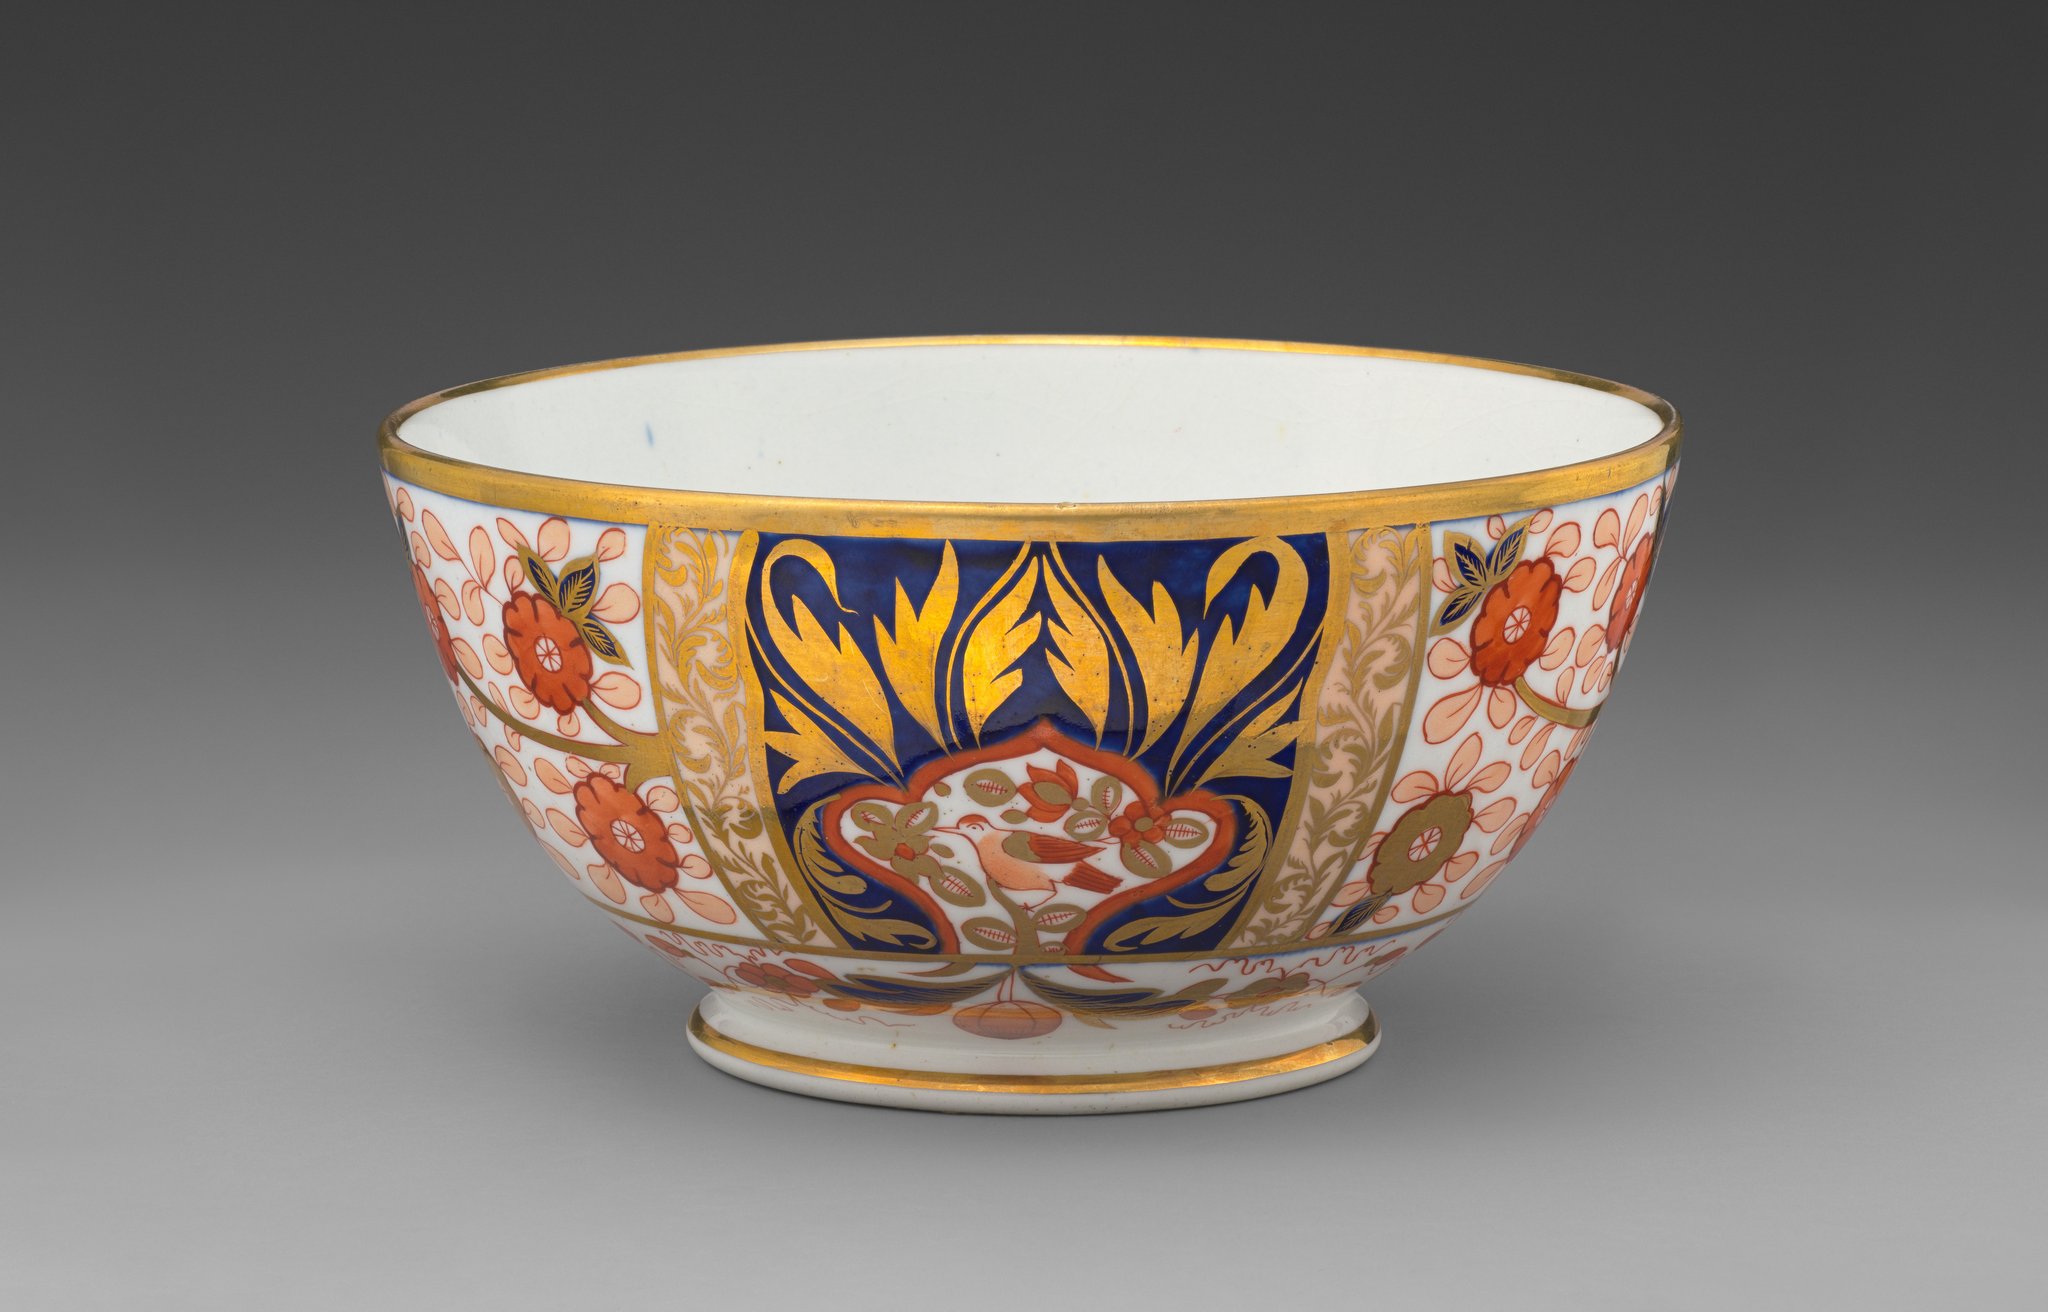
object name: bowl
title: Bowl (part of a service)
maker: j. spode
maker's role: factory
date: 1800-1830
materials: soft paste porcelain